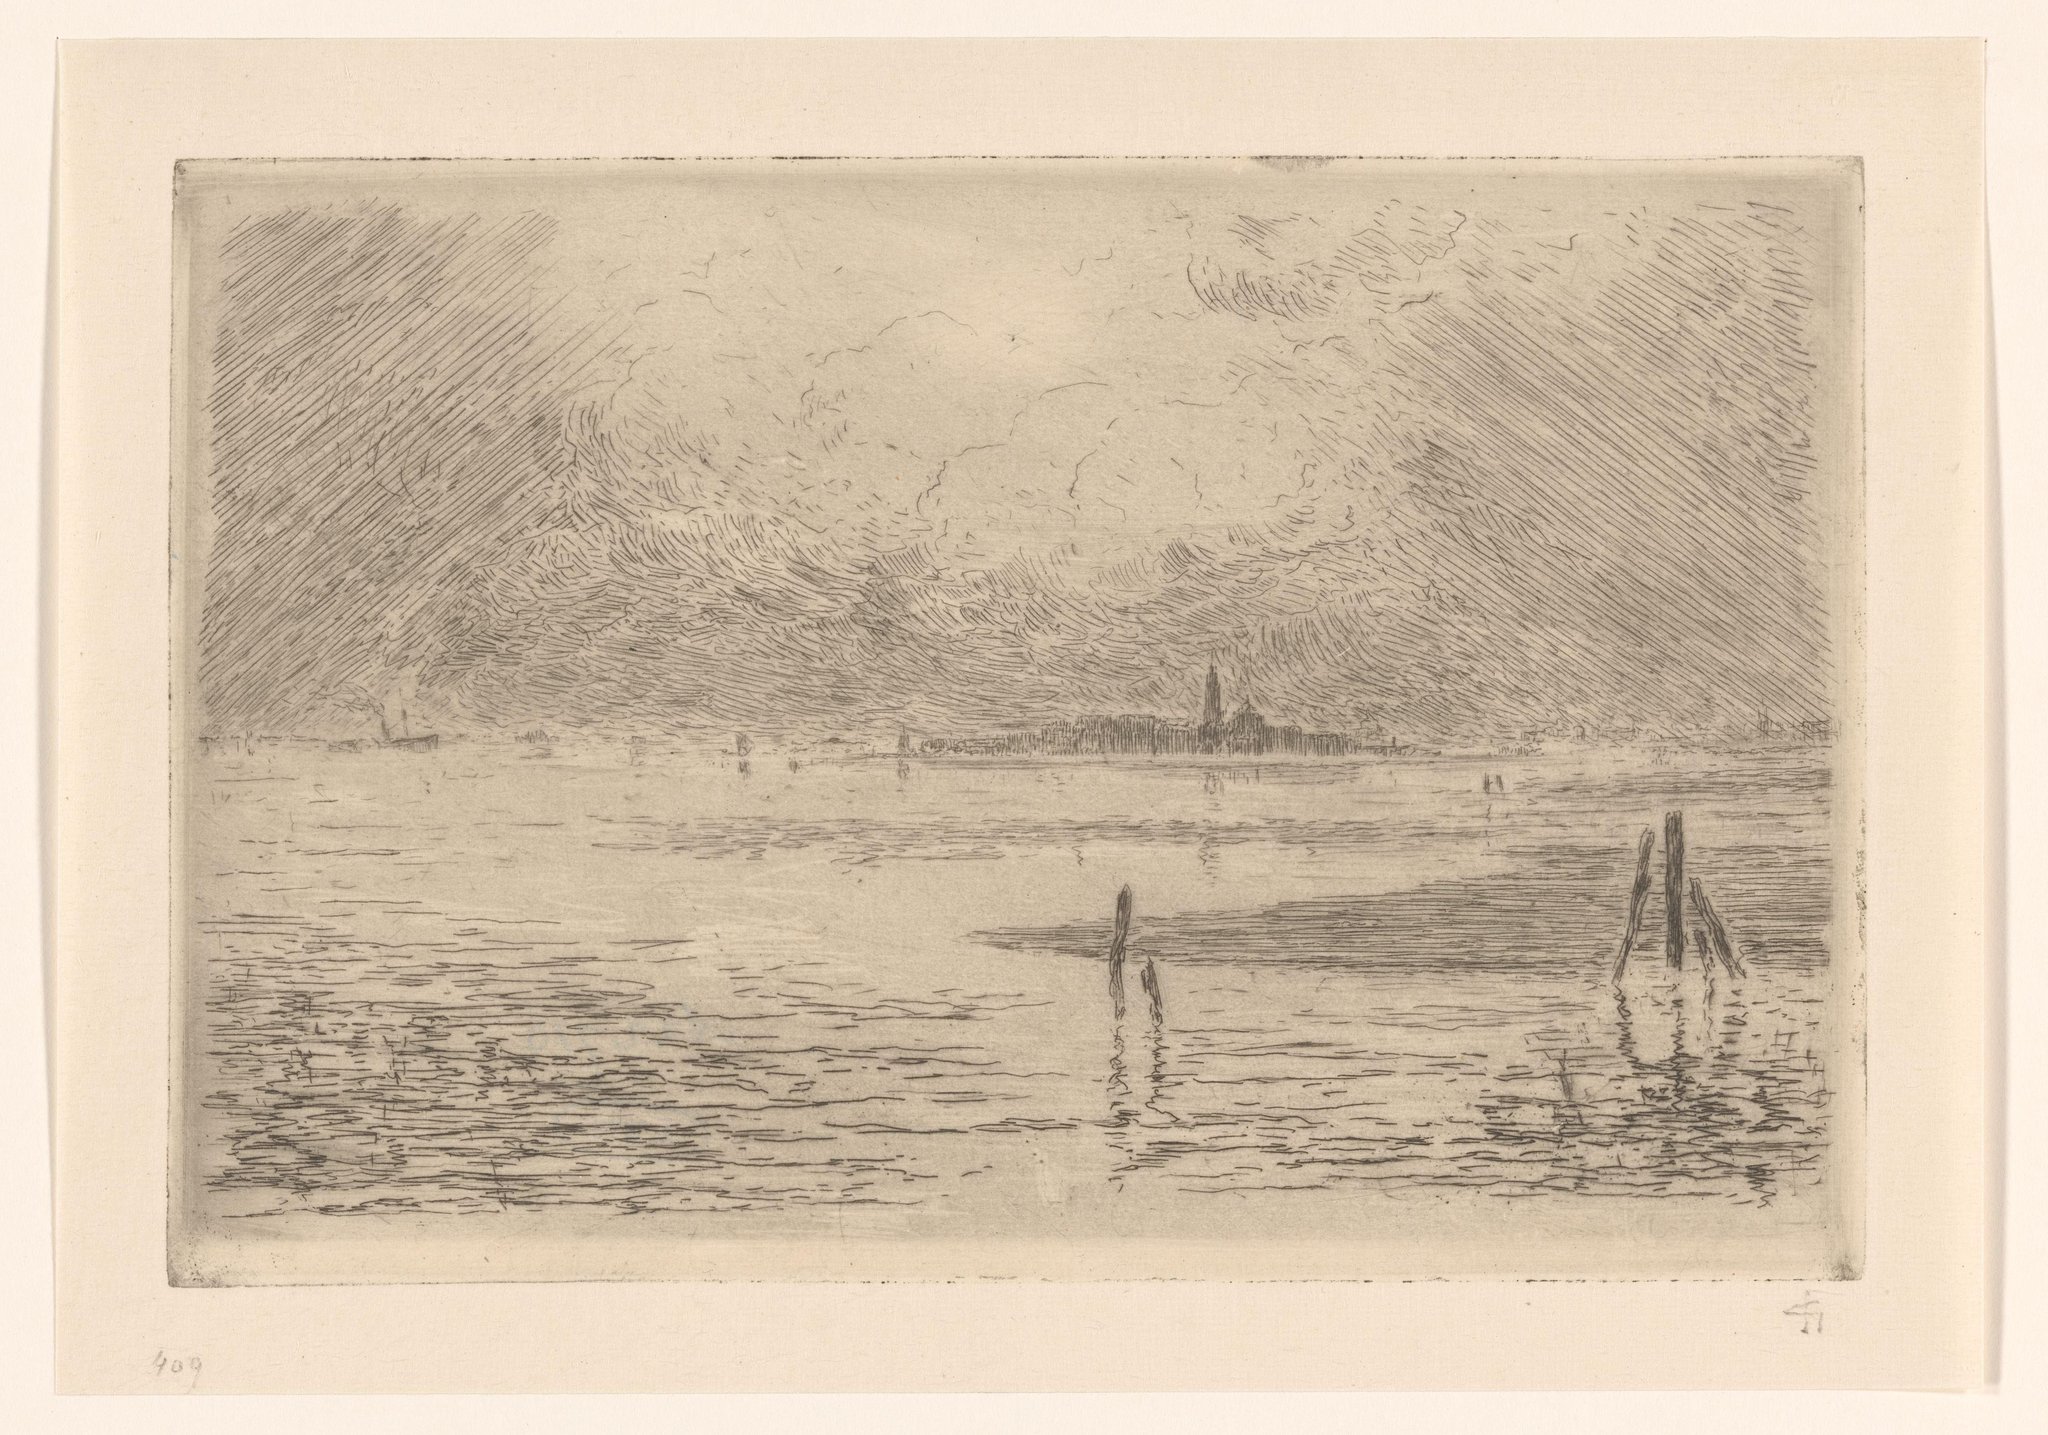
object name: print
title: Gezicht op de Lagune van Venetië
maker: carel nicolaas storm van s-gravesande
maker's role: draughtsman, print maker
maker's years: 1841-1924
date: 1851-1902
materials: paper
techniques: etching, intaglio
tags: haff, lagoon created by sand, shingle bank ~ coast, prospect of city, town panorama, silhouette of city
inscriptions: number: ‘409’, collector's mark: Lugt 2228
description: Mogelijk vermeld in: Storm van 's-Gravesande, Charles. Catalogue des eaux-fortes et lithographies. New York: s.n., 1903, of in een onbekende latere uitgave van het manuscript. Vermoedelijk vermeld als catalogusnummer 409.